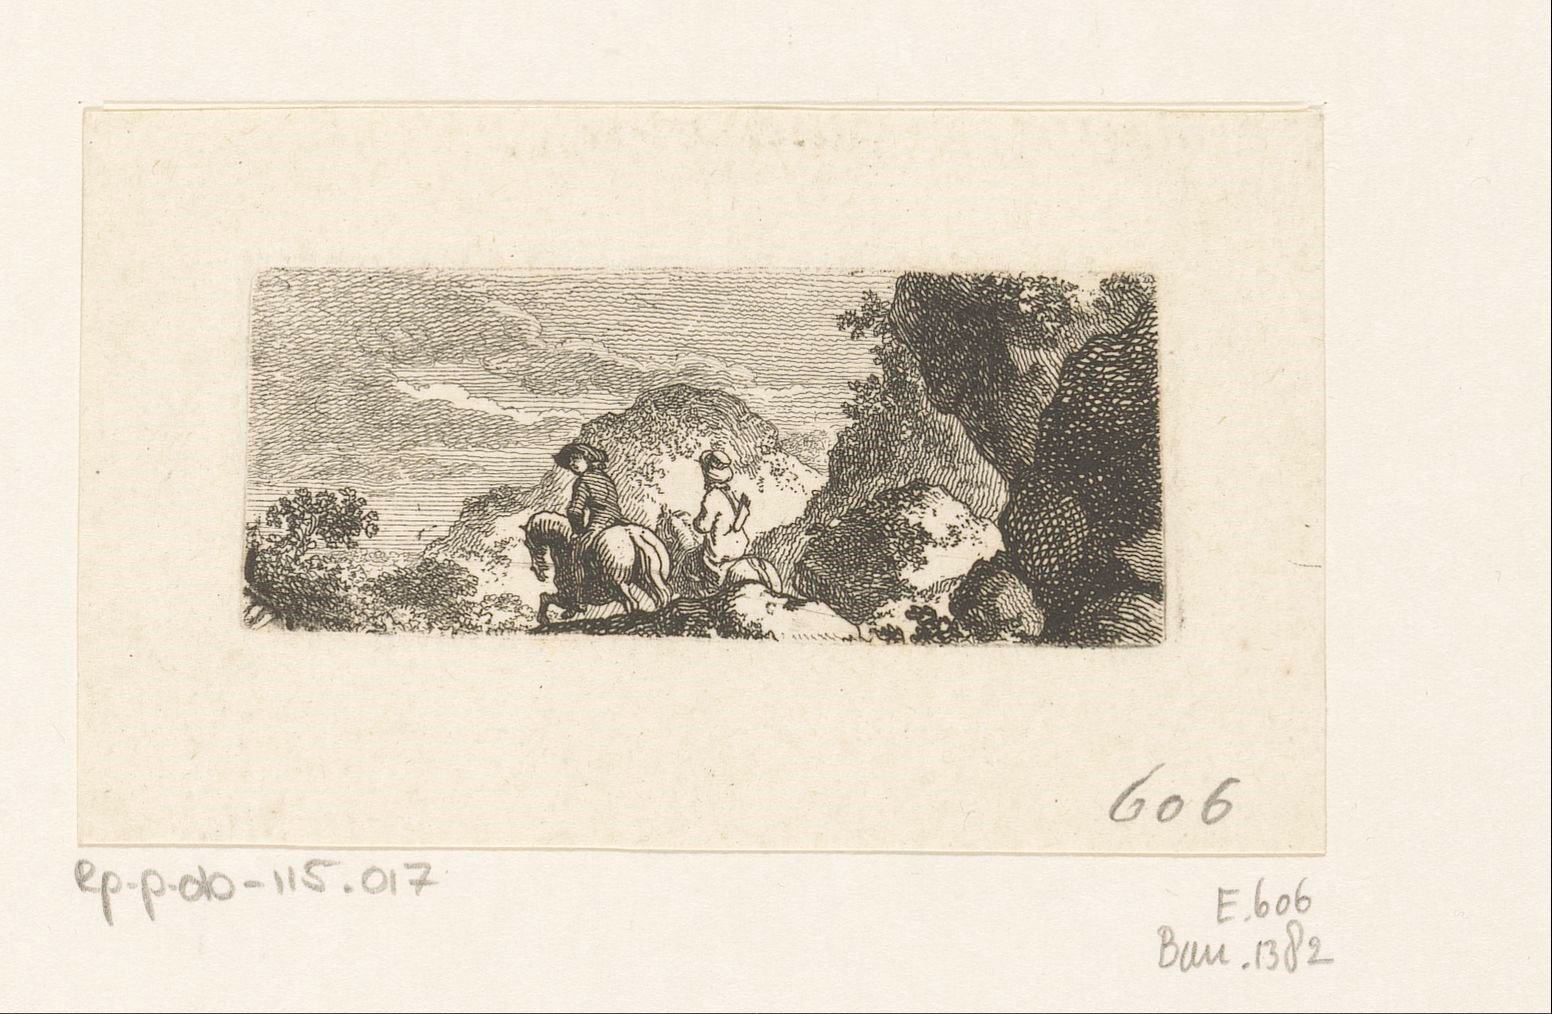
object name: print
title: Twee mannen te paard in rotsachtig landschap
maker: daniel nikolaus chodowiecki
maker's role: draughtsman, print maker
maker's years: 1726-1801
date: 1789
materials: paper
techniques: etching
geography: berlin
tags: riding a horse, ass, or mule; rider, horseman, landscapes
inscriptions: collector's mark: Lugt 2228